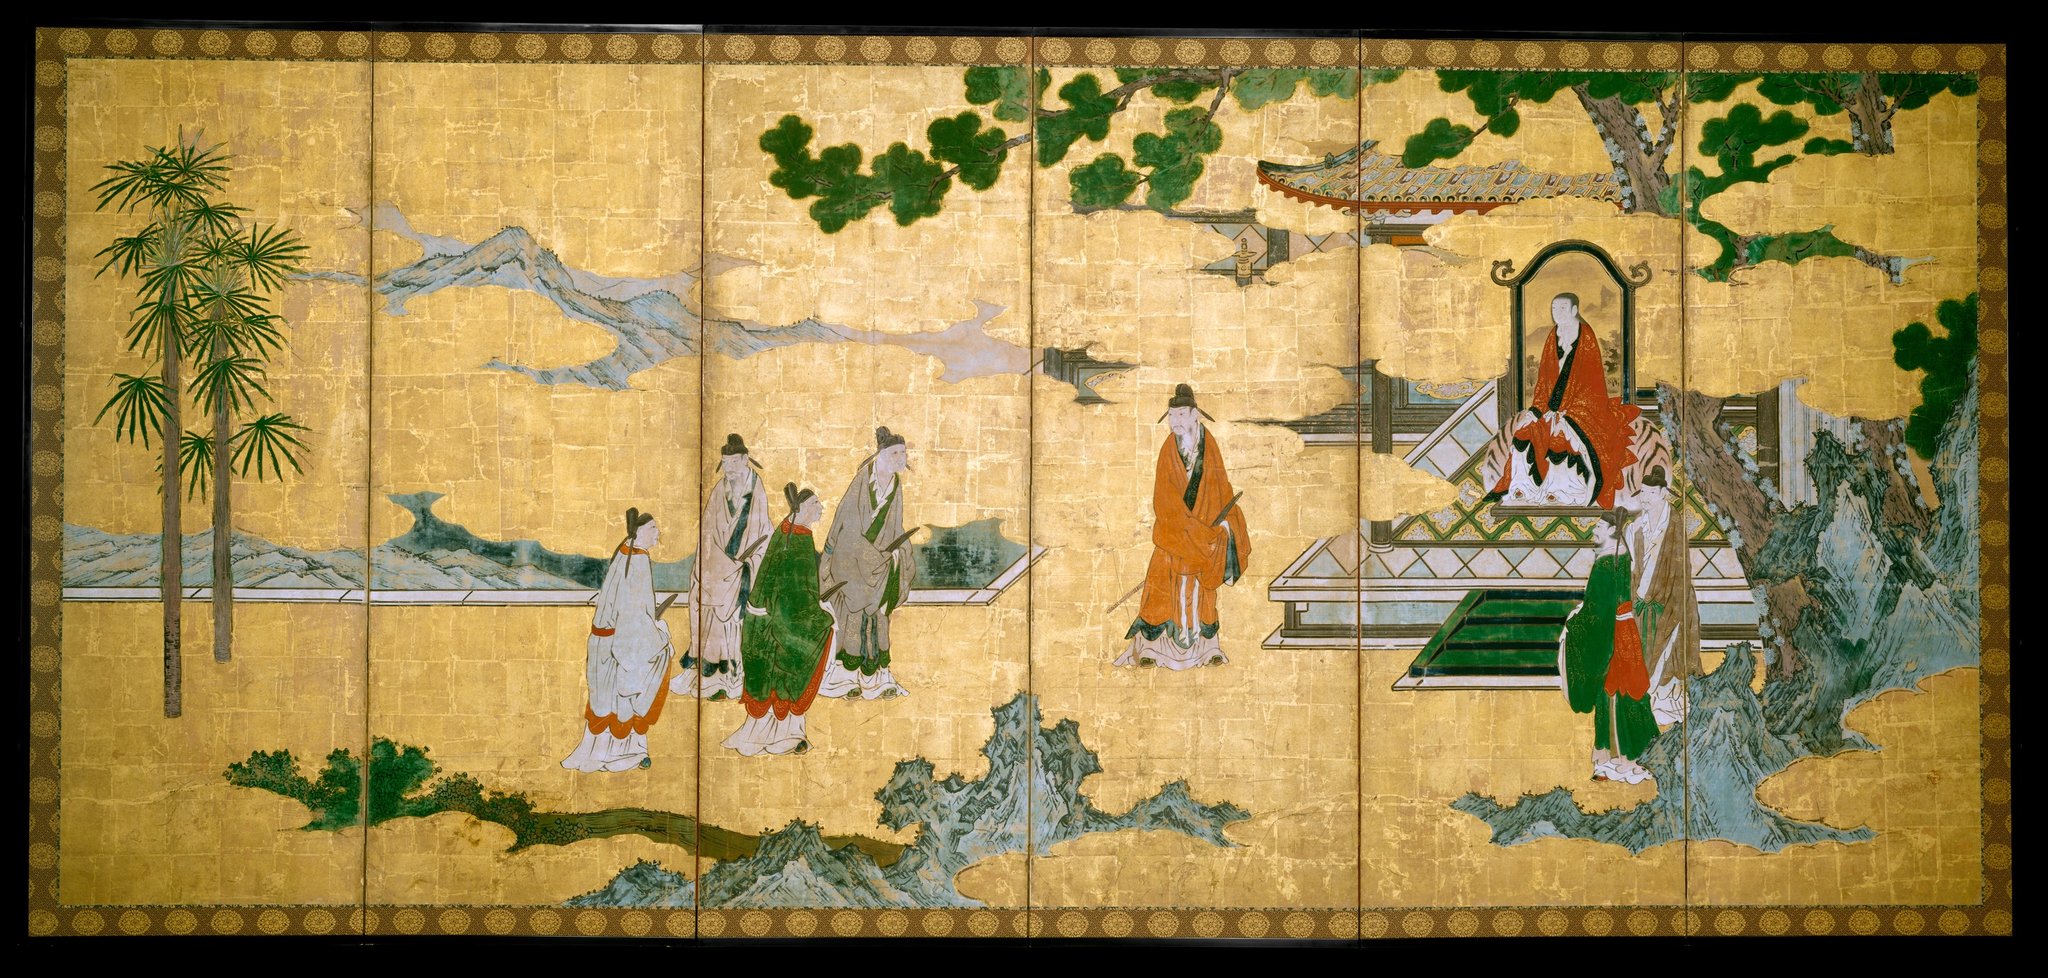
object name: screen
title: The Return to Court of the Four Graybeards of Mount Shang (left); Su Shi’s Visit to the Wind and Water Cave (right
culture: japanese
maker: kano mitsunobu 狩野光信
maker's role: artist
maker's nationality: japanese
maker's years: 1565-1608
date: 1567-1600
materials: gold, gold leaf, ink, panel, paper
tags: men,horses,trees